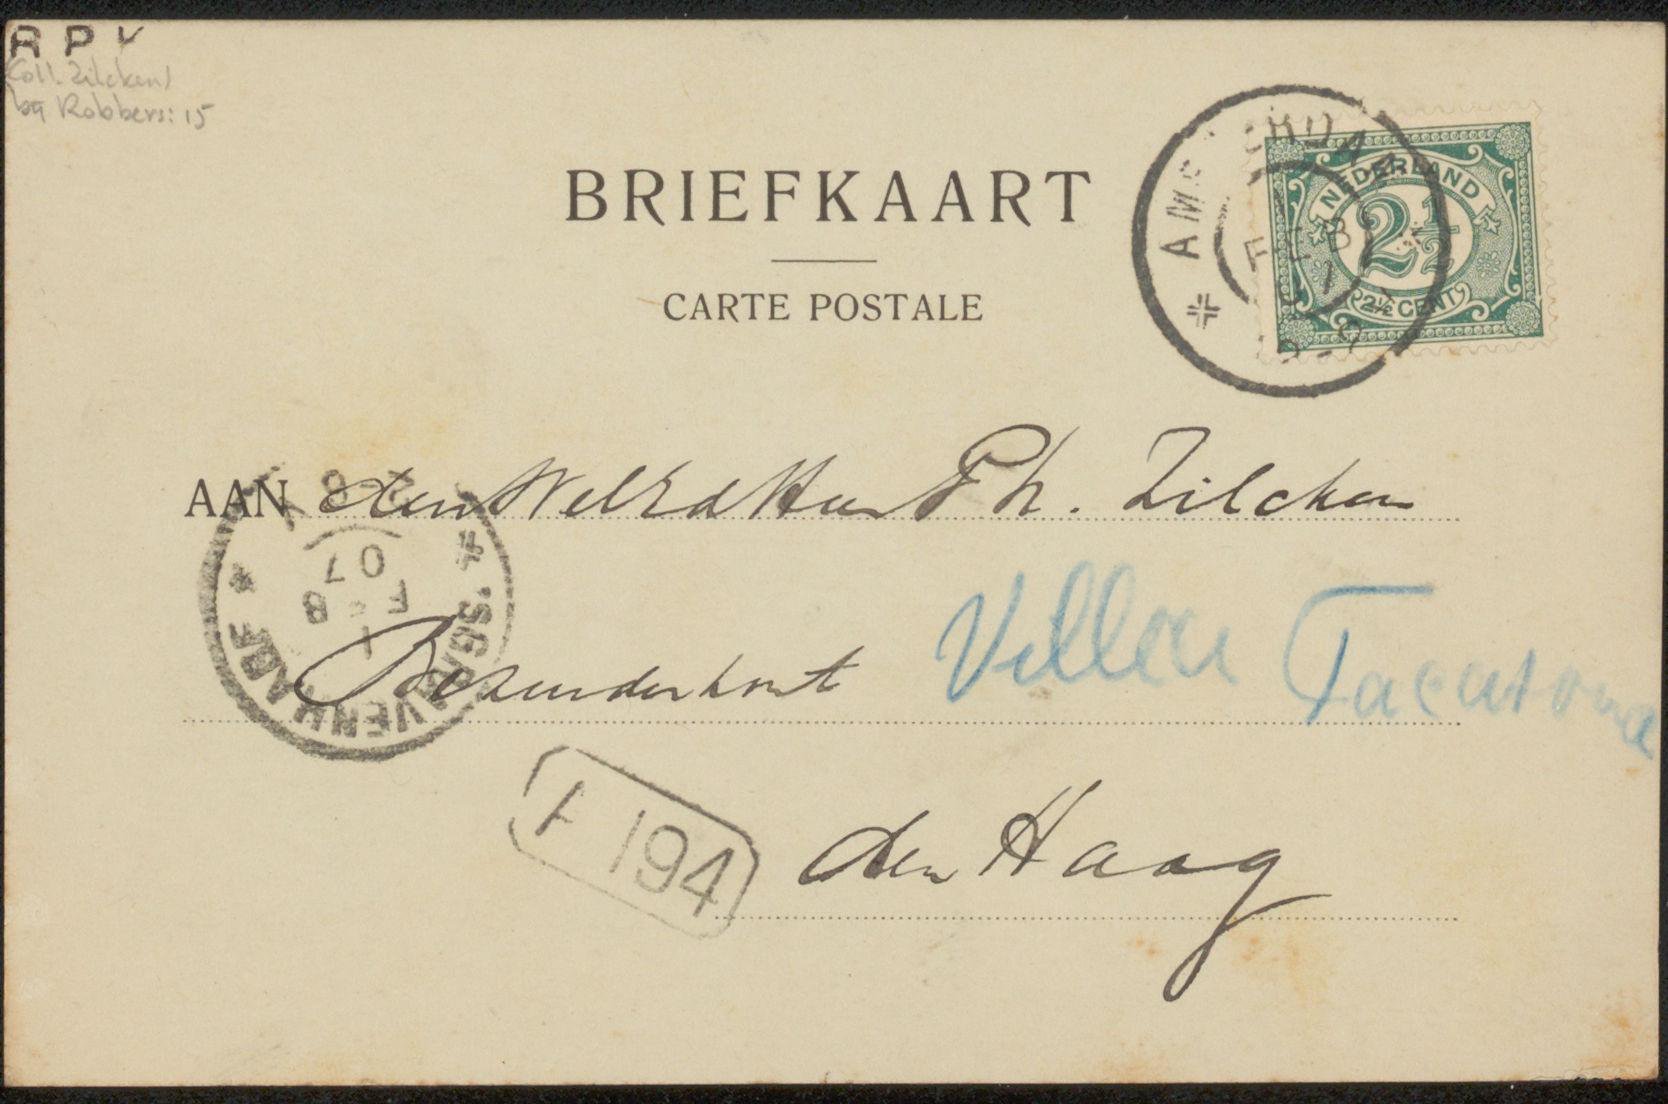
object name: postcard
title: Briefkaart aan Philip Zilcken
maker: herman robbers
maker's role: redacteur, schrijver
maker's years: 1868-1937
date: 1907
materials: cardboard, ink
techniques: pen, printing, writing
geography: amsterdam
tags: delft, print maker, antoon derkzen van angeren, the hague, painter, draughtsman, philip zilcken, the graphic arts, printed matter, venice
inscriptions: collector's mark: ‘RPK’